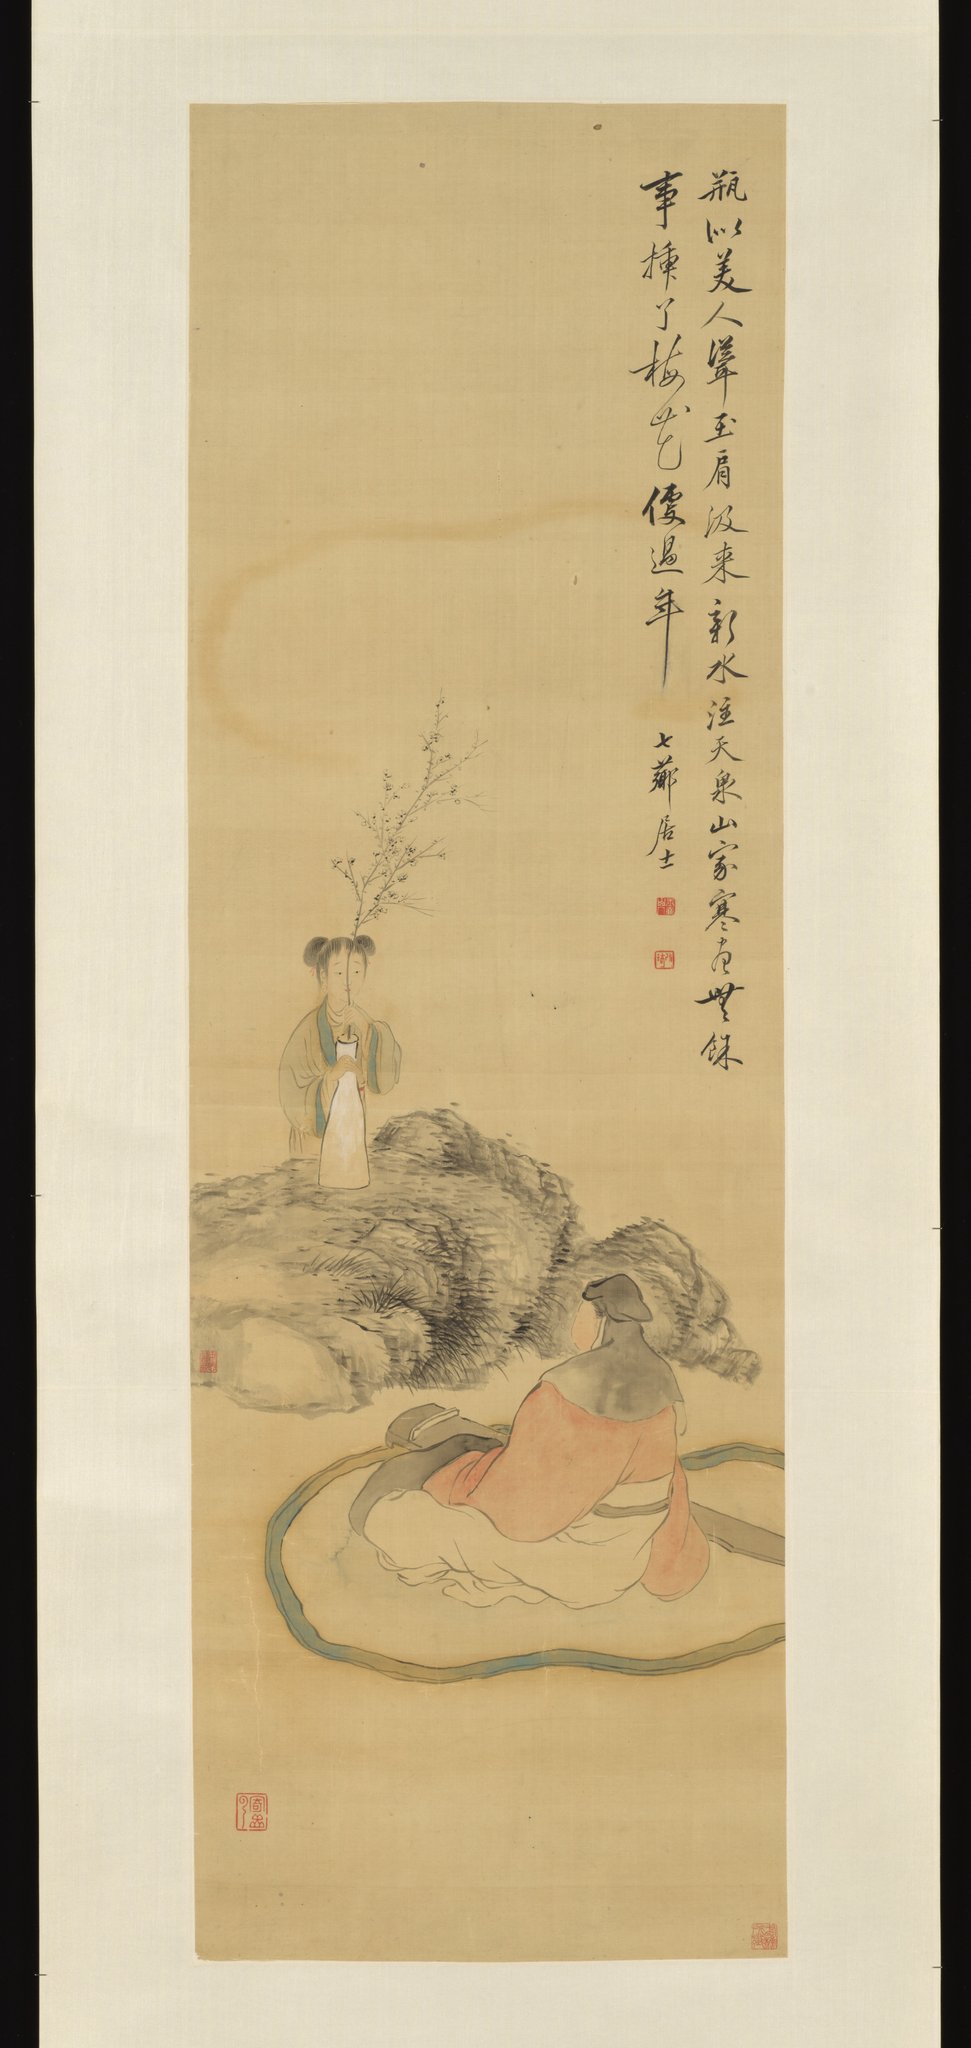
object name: hanging scroll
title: Girl Arranging Flowers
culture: chinese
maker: gai qi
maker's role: artist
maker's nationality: chinese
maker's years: 1773-1828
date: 1774-1829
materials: ink, silk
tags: girls